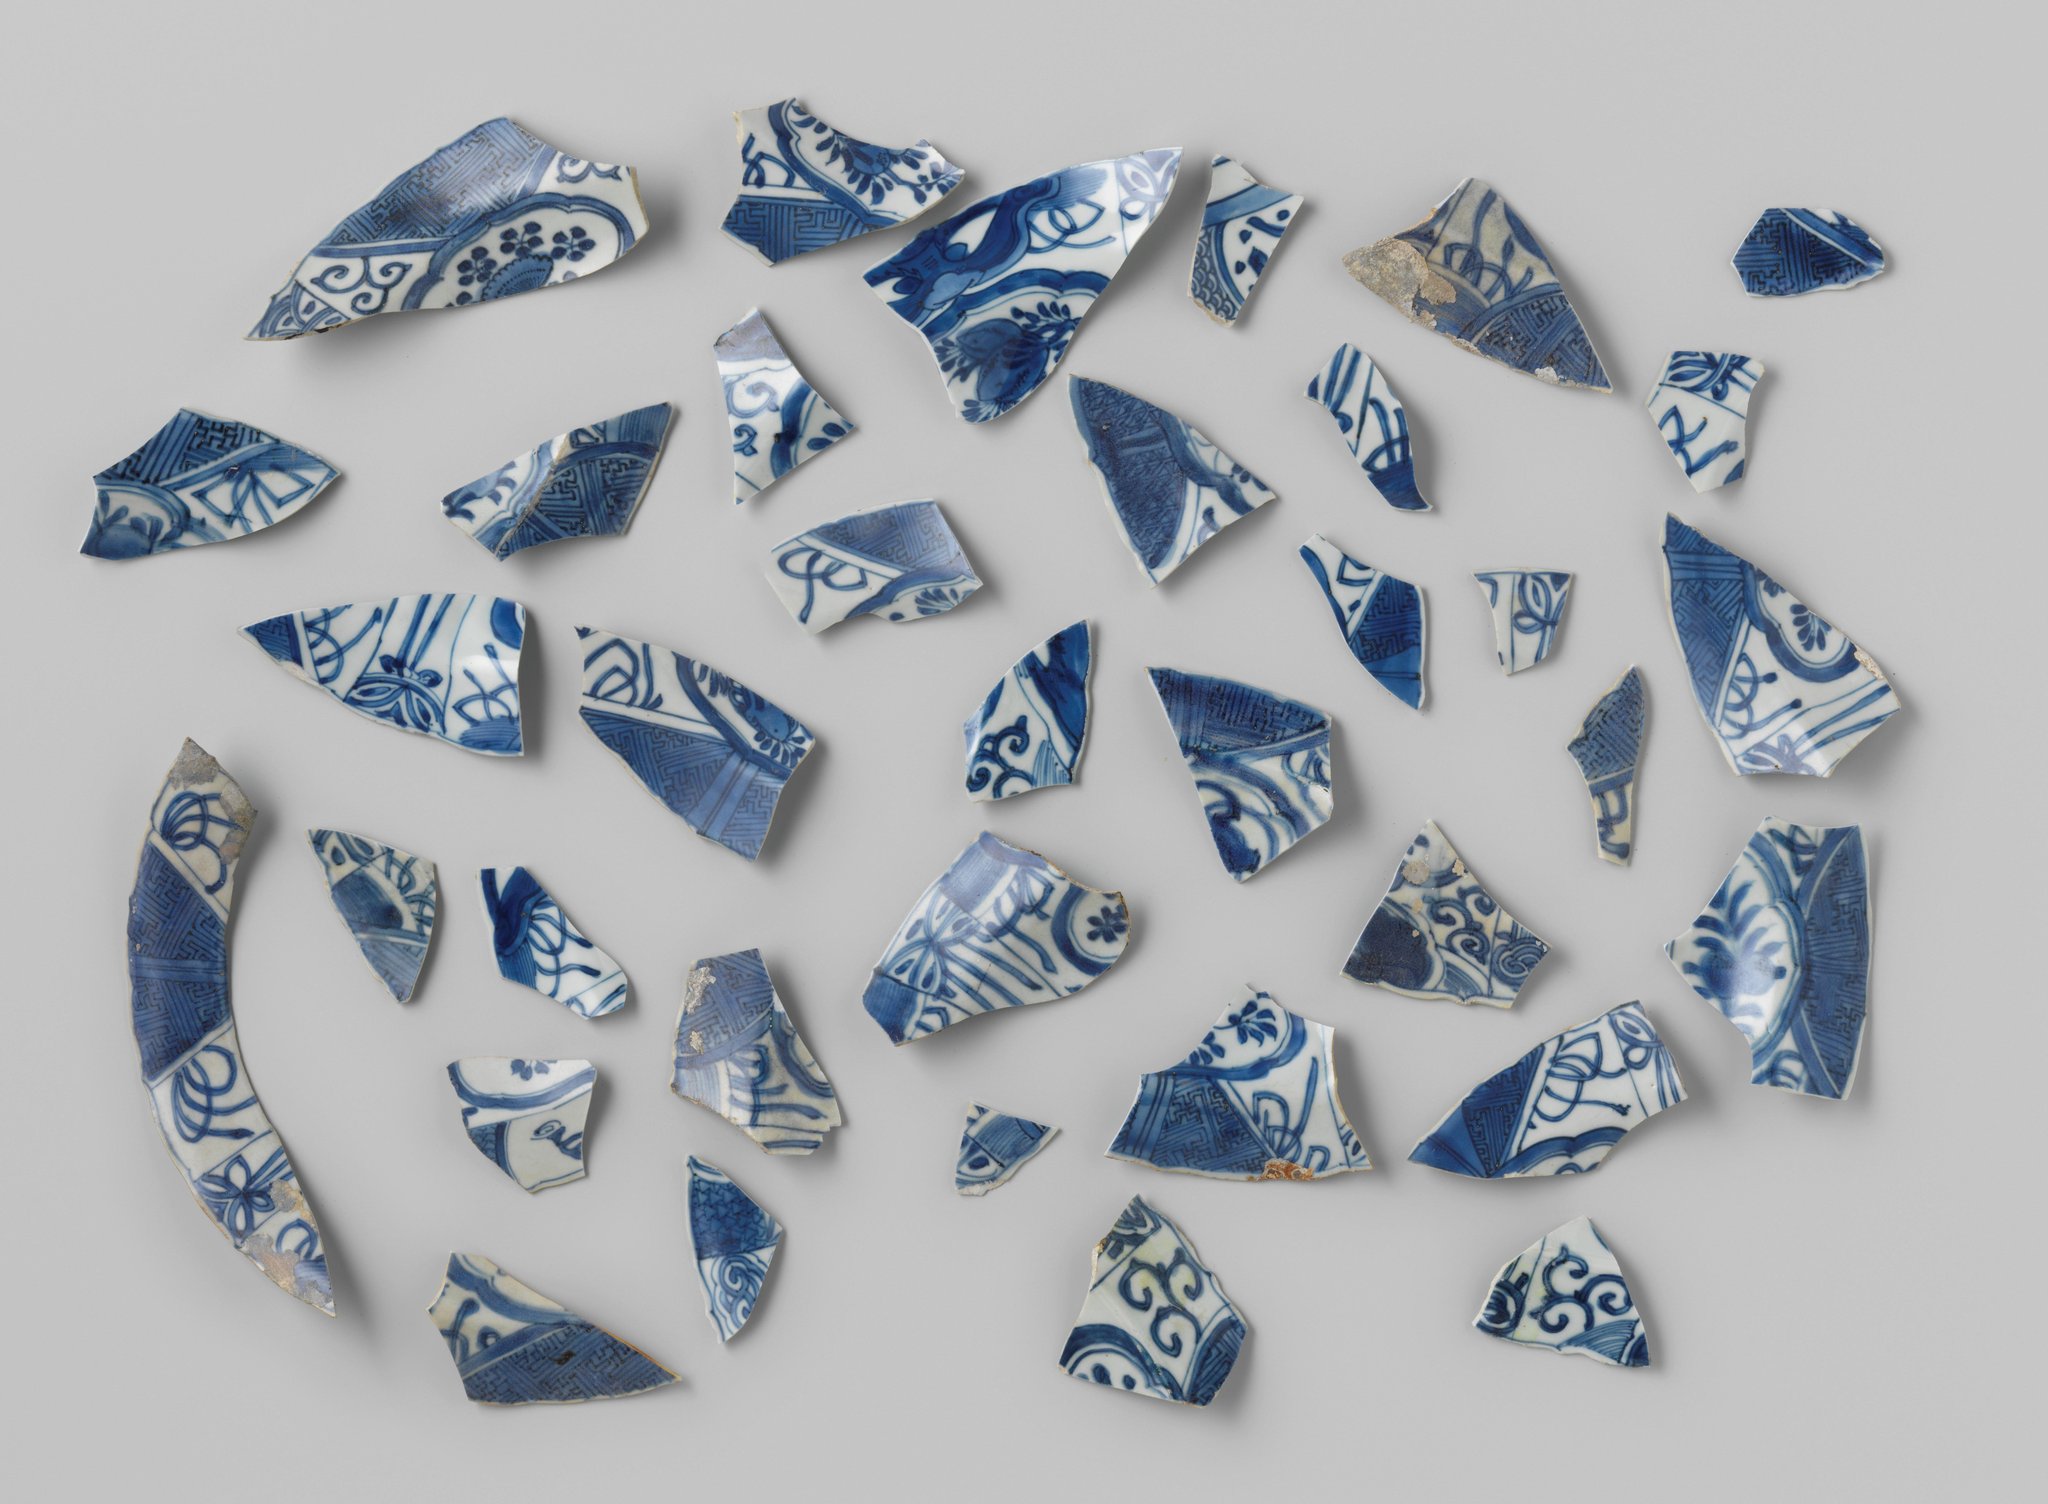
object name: sherd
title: Scherven kraakporselein uit V.O.C.-schip de 'Witte Leeuw'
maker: Anonymous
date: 1613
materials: bone china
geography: jingdezhen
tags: verenigde oostindische compagnie, sint-helena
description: Scherven kraakporselein uit V.O.C.-schip de 'Witte Leeuw'.